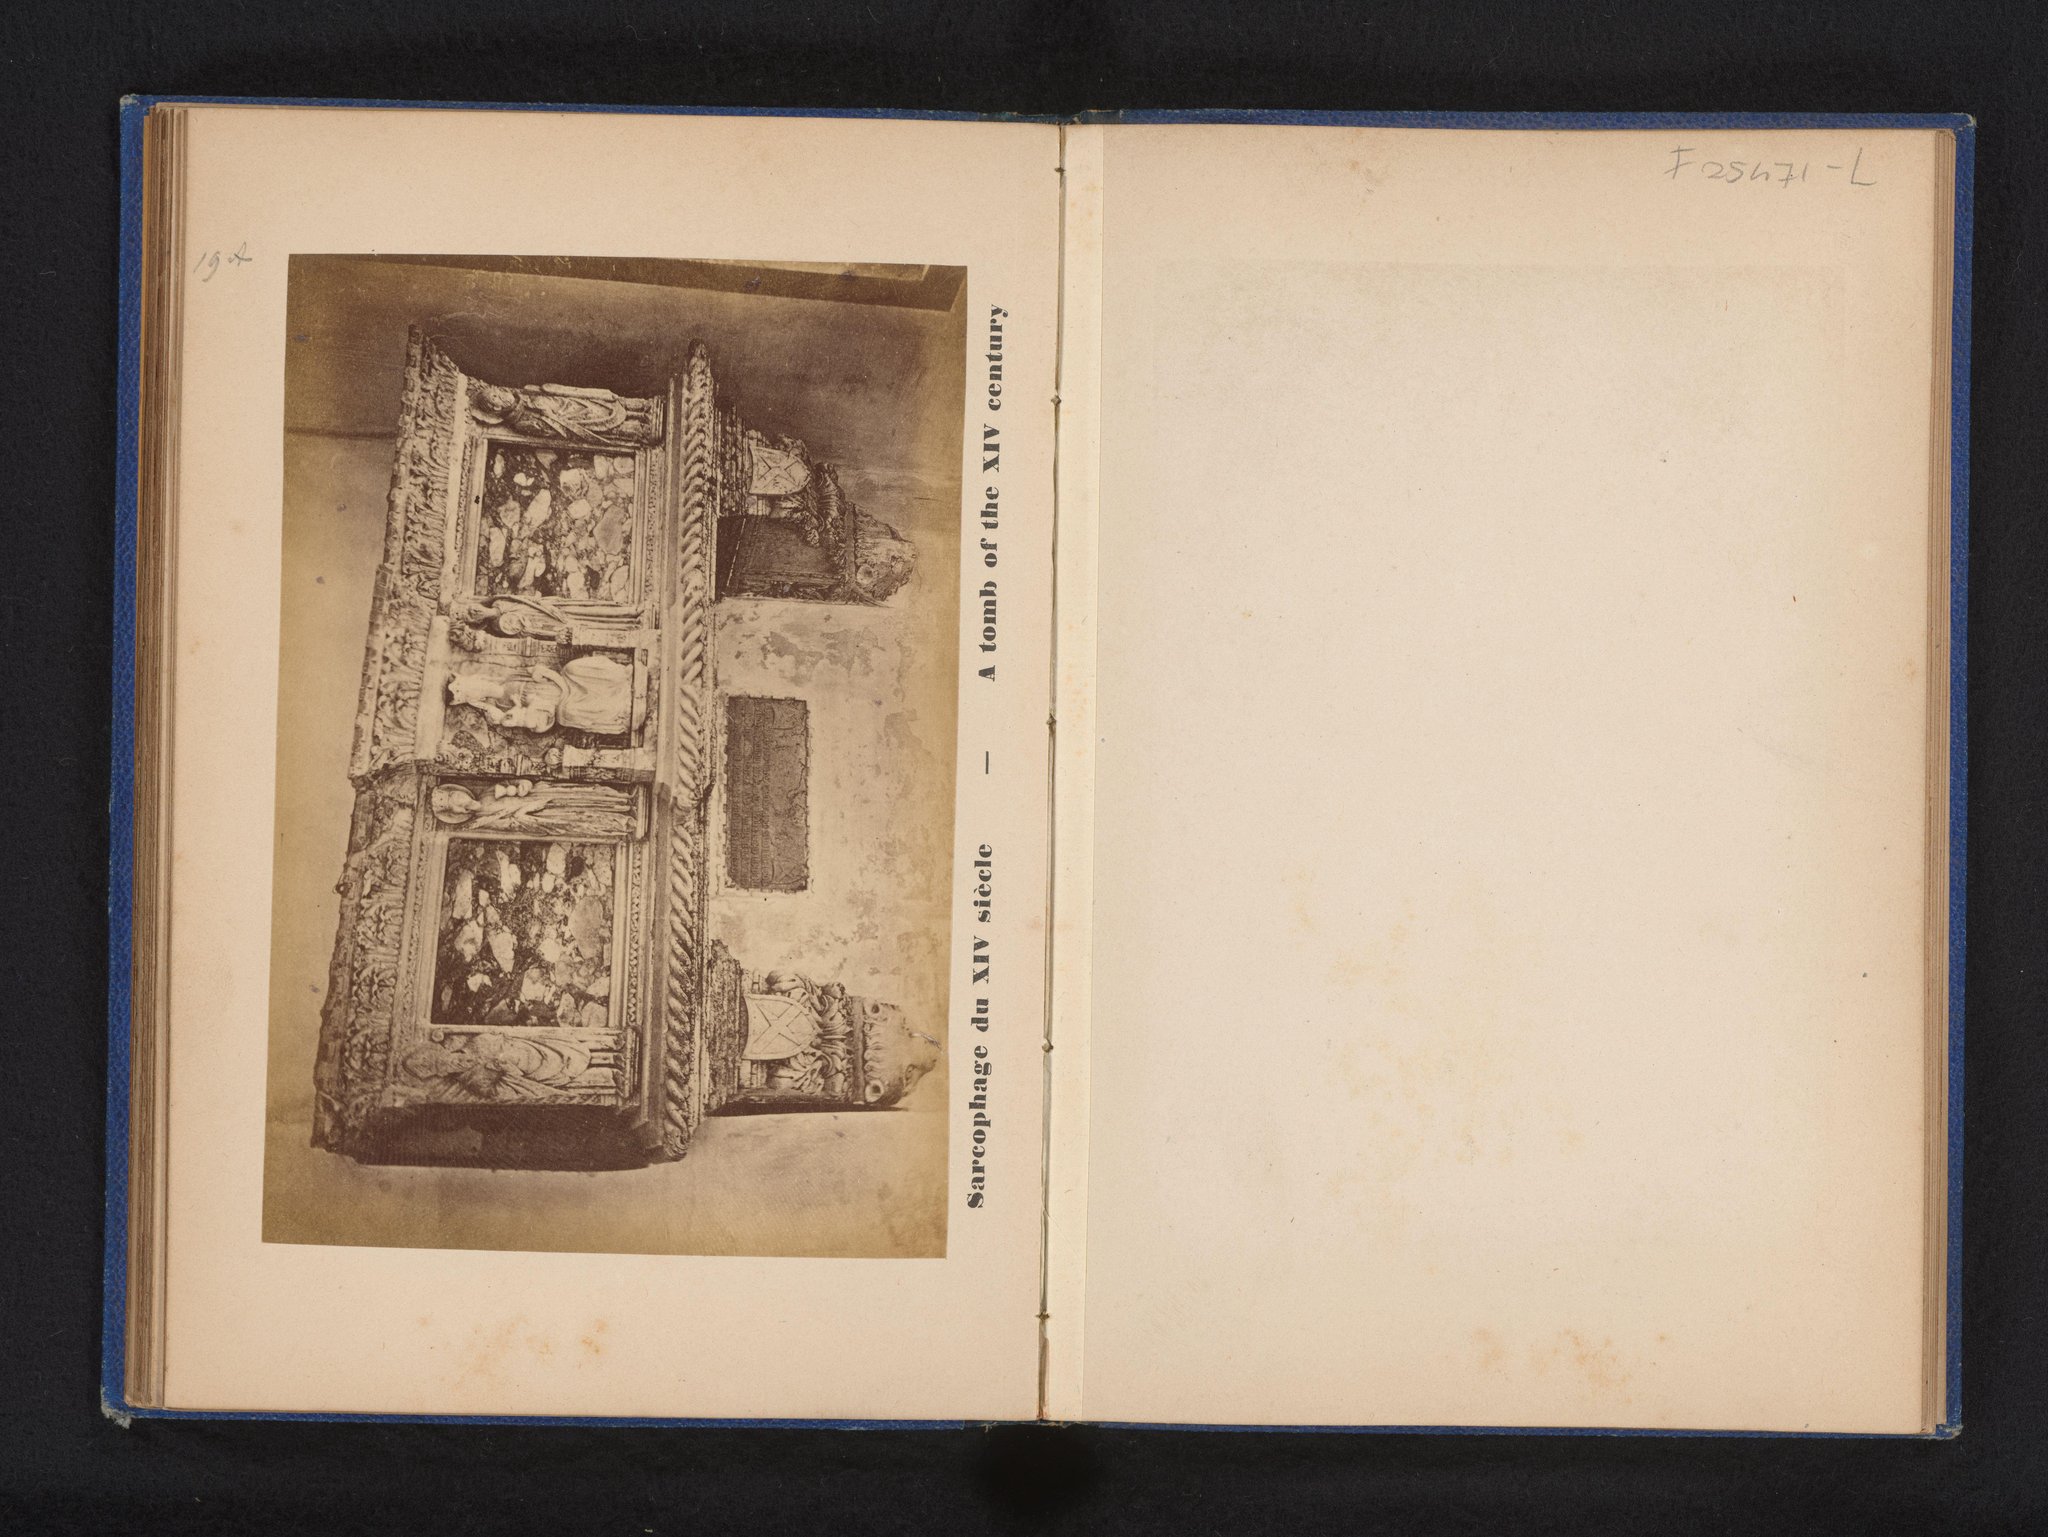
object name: page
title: Sarcophage du XIV siècle / A tomb of the XIV century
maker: Anonymous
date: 1874-1879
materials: paper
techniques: albumen print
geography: venice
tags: sarcophagus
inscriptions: number: ‘19A’